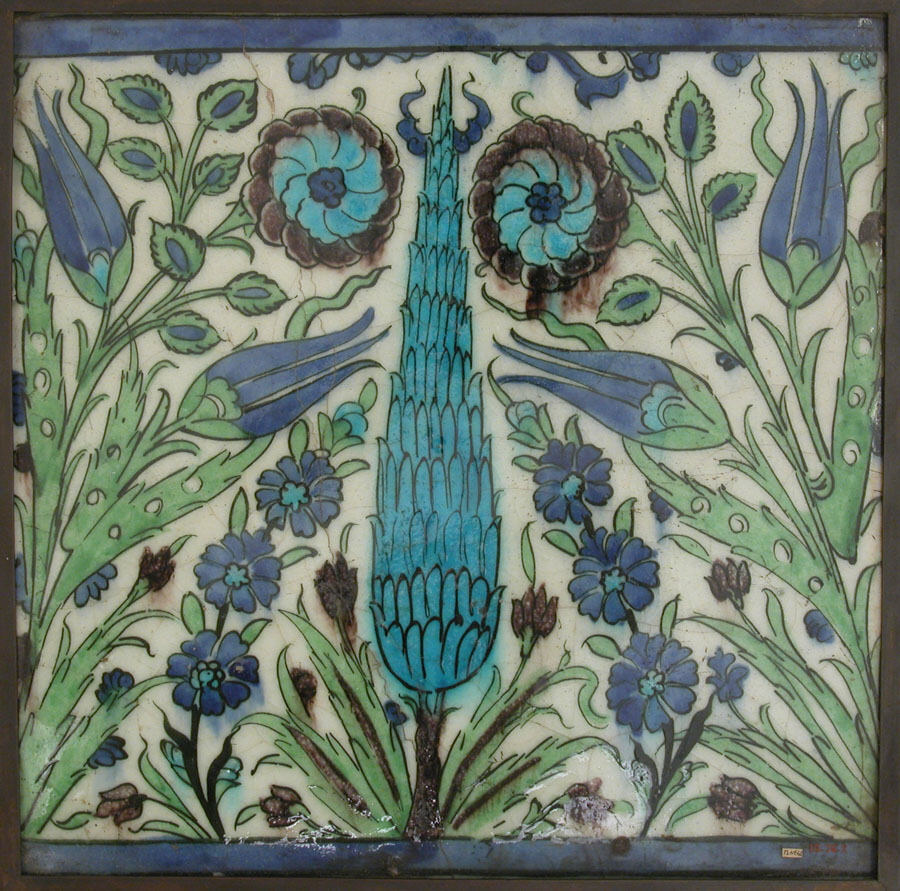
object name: tile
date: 1601-1650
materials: stonepaste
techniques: glazing, painting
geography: syria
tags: flowers,leaves